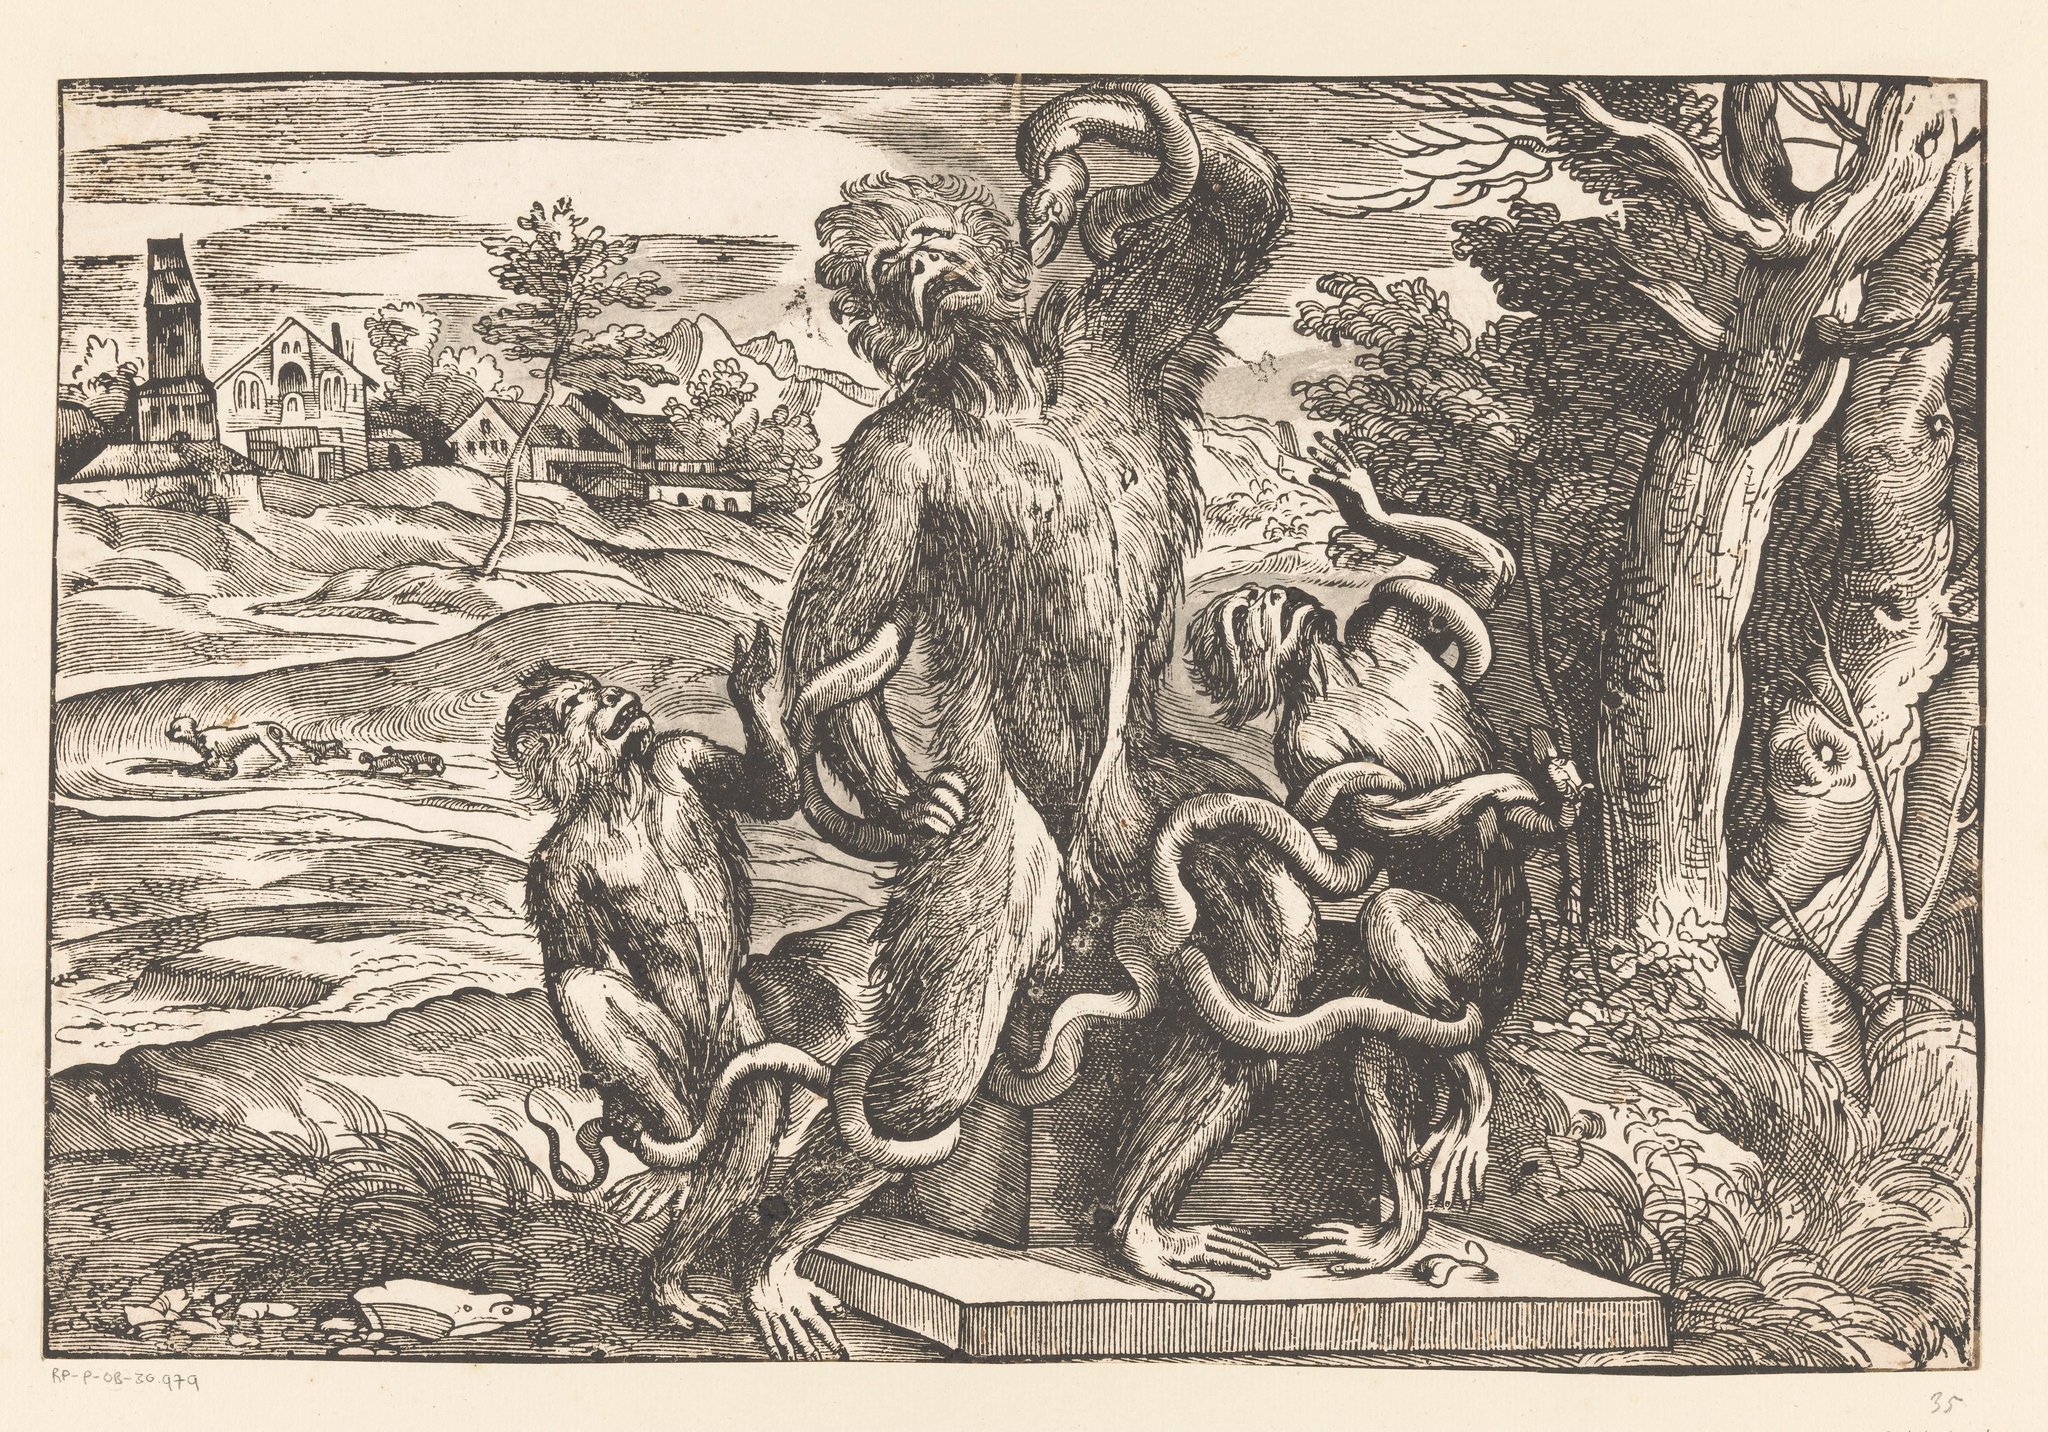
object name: print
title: Karikatuur op de Laocoöngroep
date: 1540-1545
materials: ink, paper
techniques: pen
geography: venice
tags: snakes, monkeys, apes, laocoon and his twin sons are strangled by two serpents during the preparations for a sacrifice, caricature of a piece of sculpture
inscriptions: collector's mark: Lugt 240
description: Karikatuur op de marmeren beeldengroep van Laocoön en zijn zonen die door twee slangen worden aangevallen, waarbij de drie menselijke figuren zijn vervangen door drie apen.